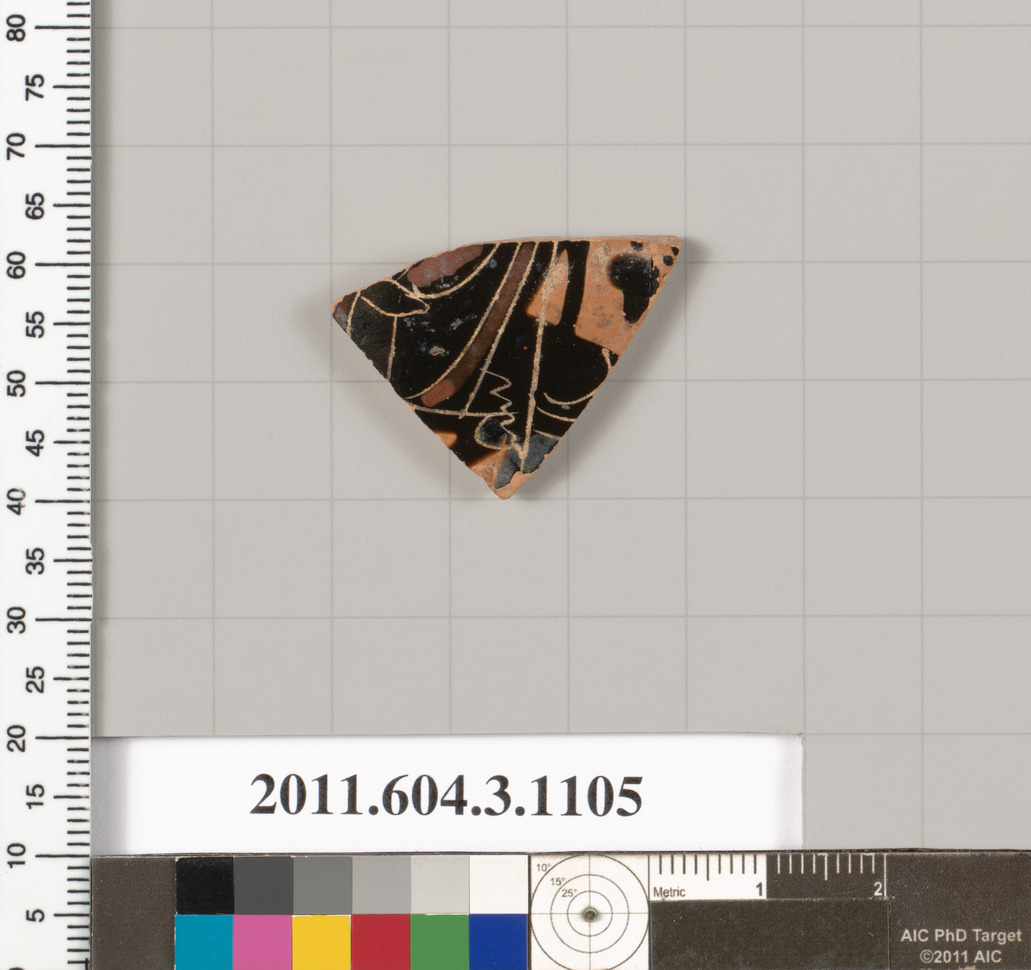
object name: mastoid or kyathos fragment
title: Terracotta fragment of a mastoid (drinking cup with narrow base) or a kyathos (cup-shaped ladle)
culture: greek, attic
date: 534-468 BCE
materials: terracotta